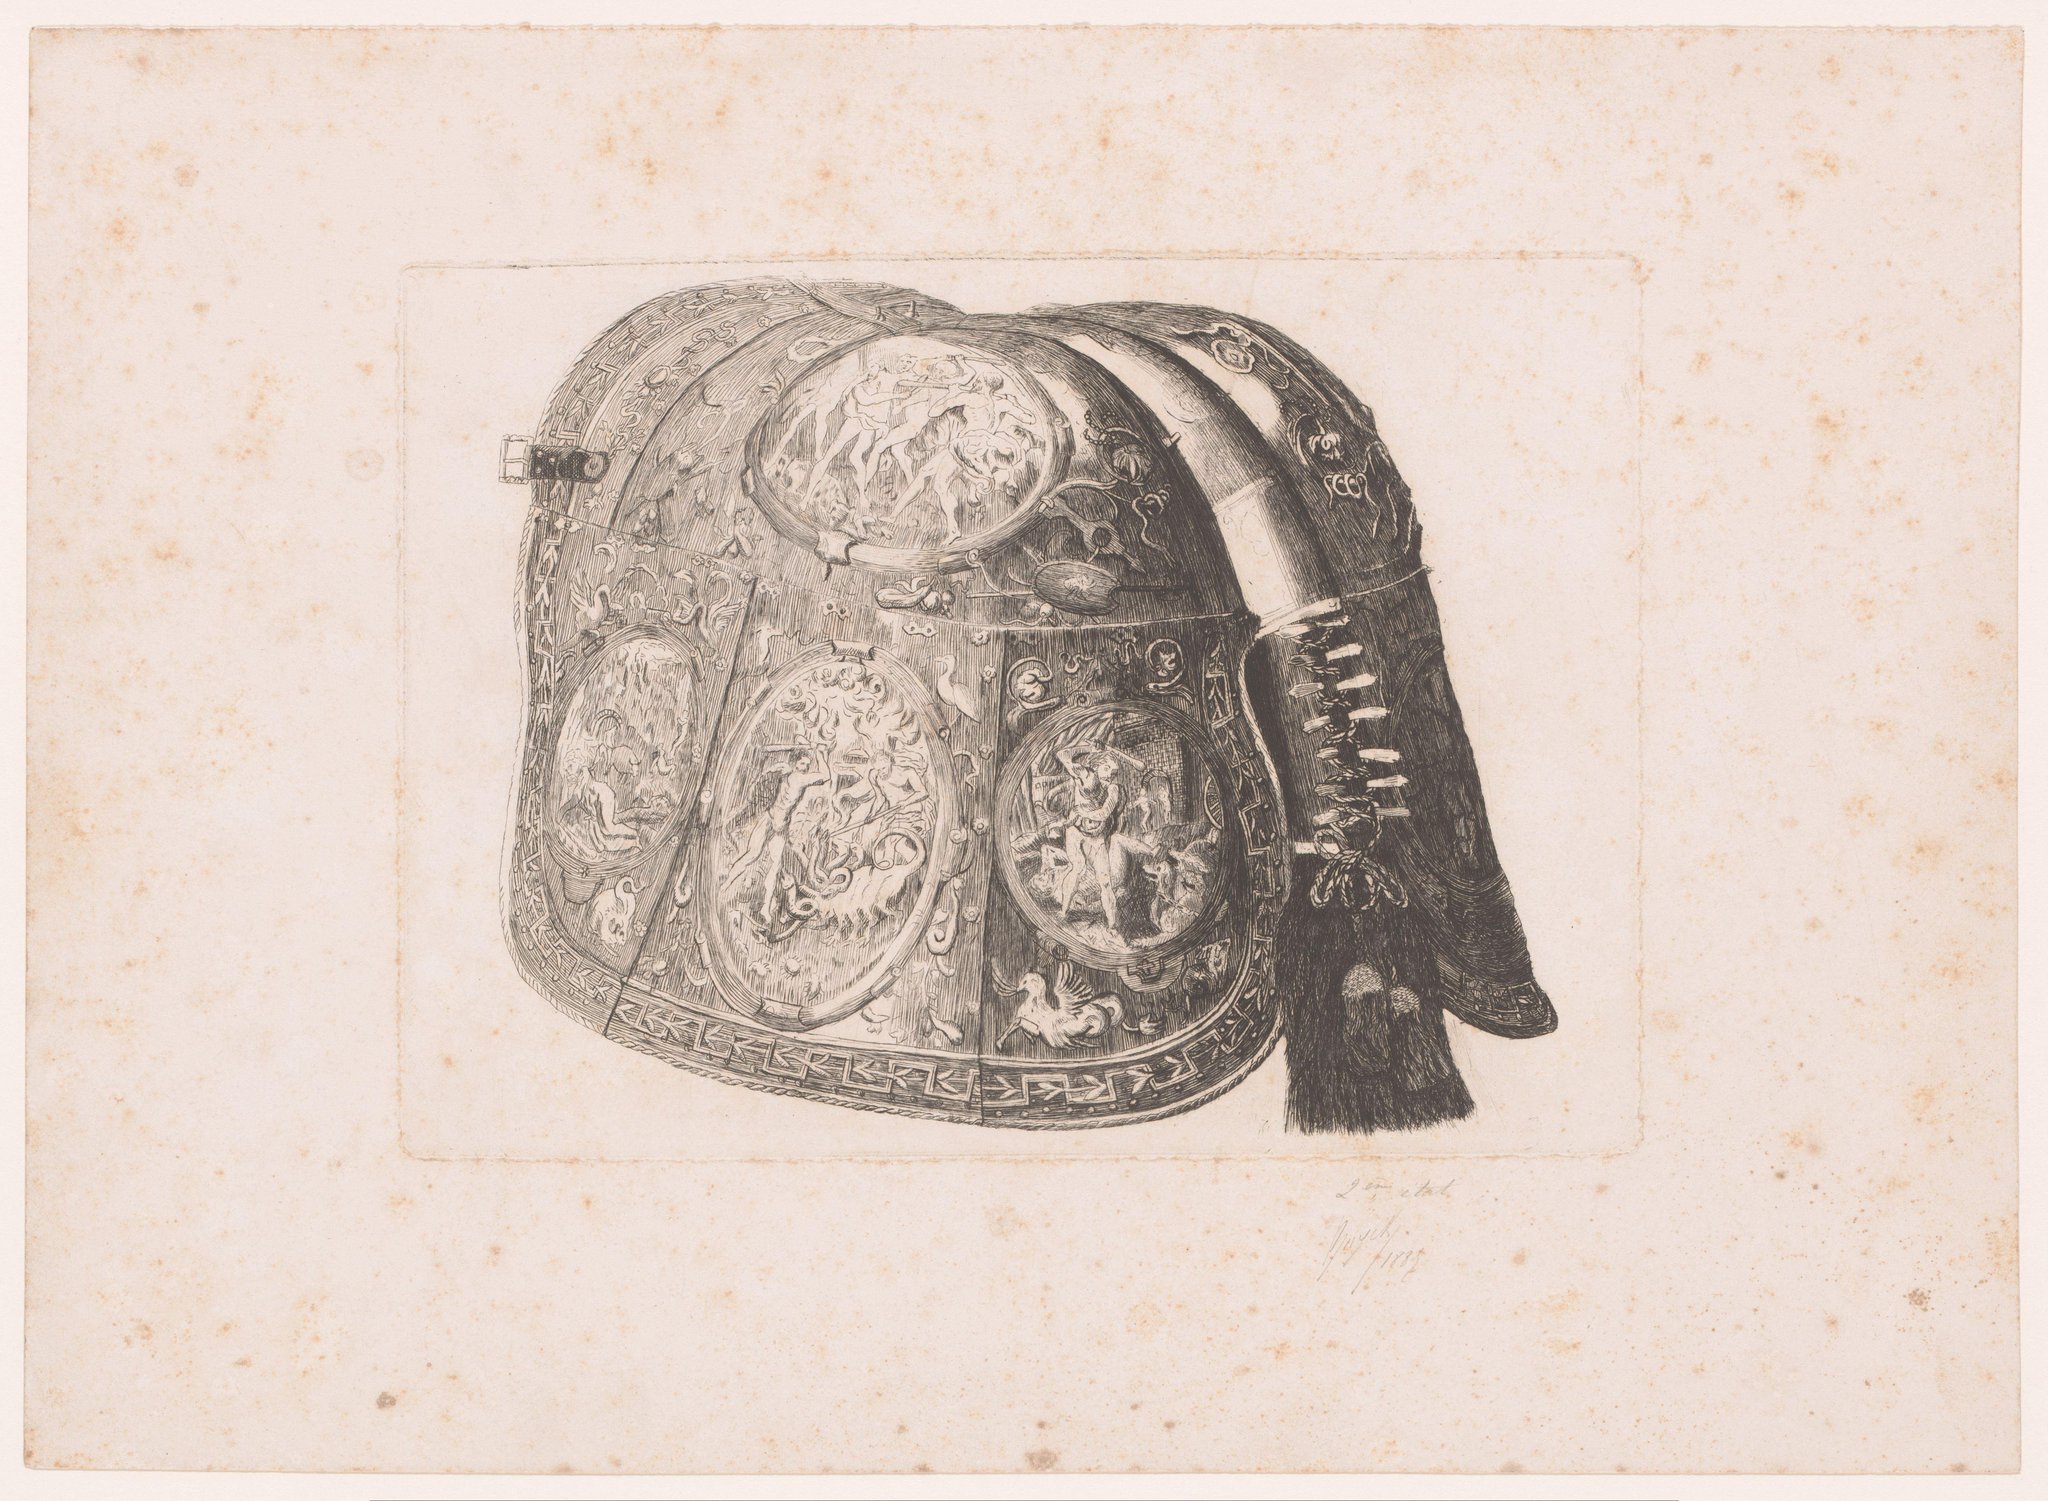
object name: print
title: Helm waarop de werken van Hercules gegraveerd zijn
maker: florimond buyck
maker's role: print maker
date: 1885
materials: paper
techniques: etching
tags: helmet, most important deeds of hercules: the twelve labours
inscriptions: collector's mark: Lugt 2228, annotation: ‘2ème état’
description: Sterfdatum prentmaker onbekend. Derhalve is voor bepaling van de rechten van dit object de verwervingsdatum aangehouden.